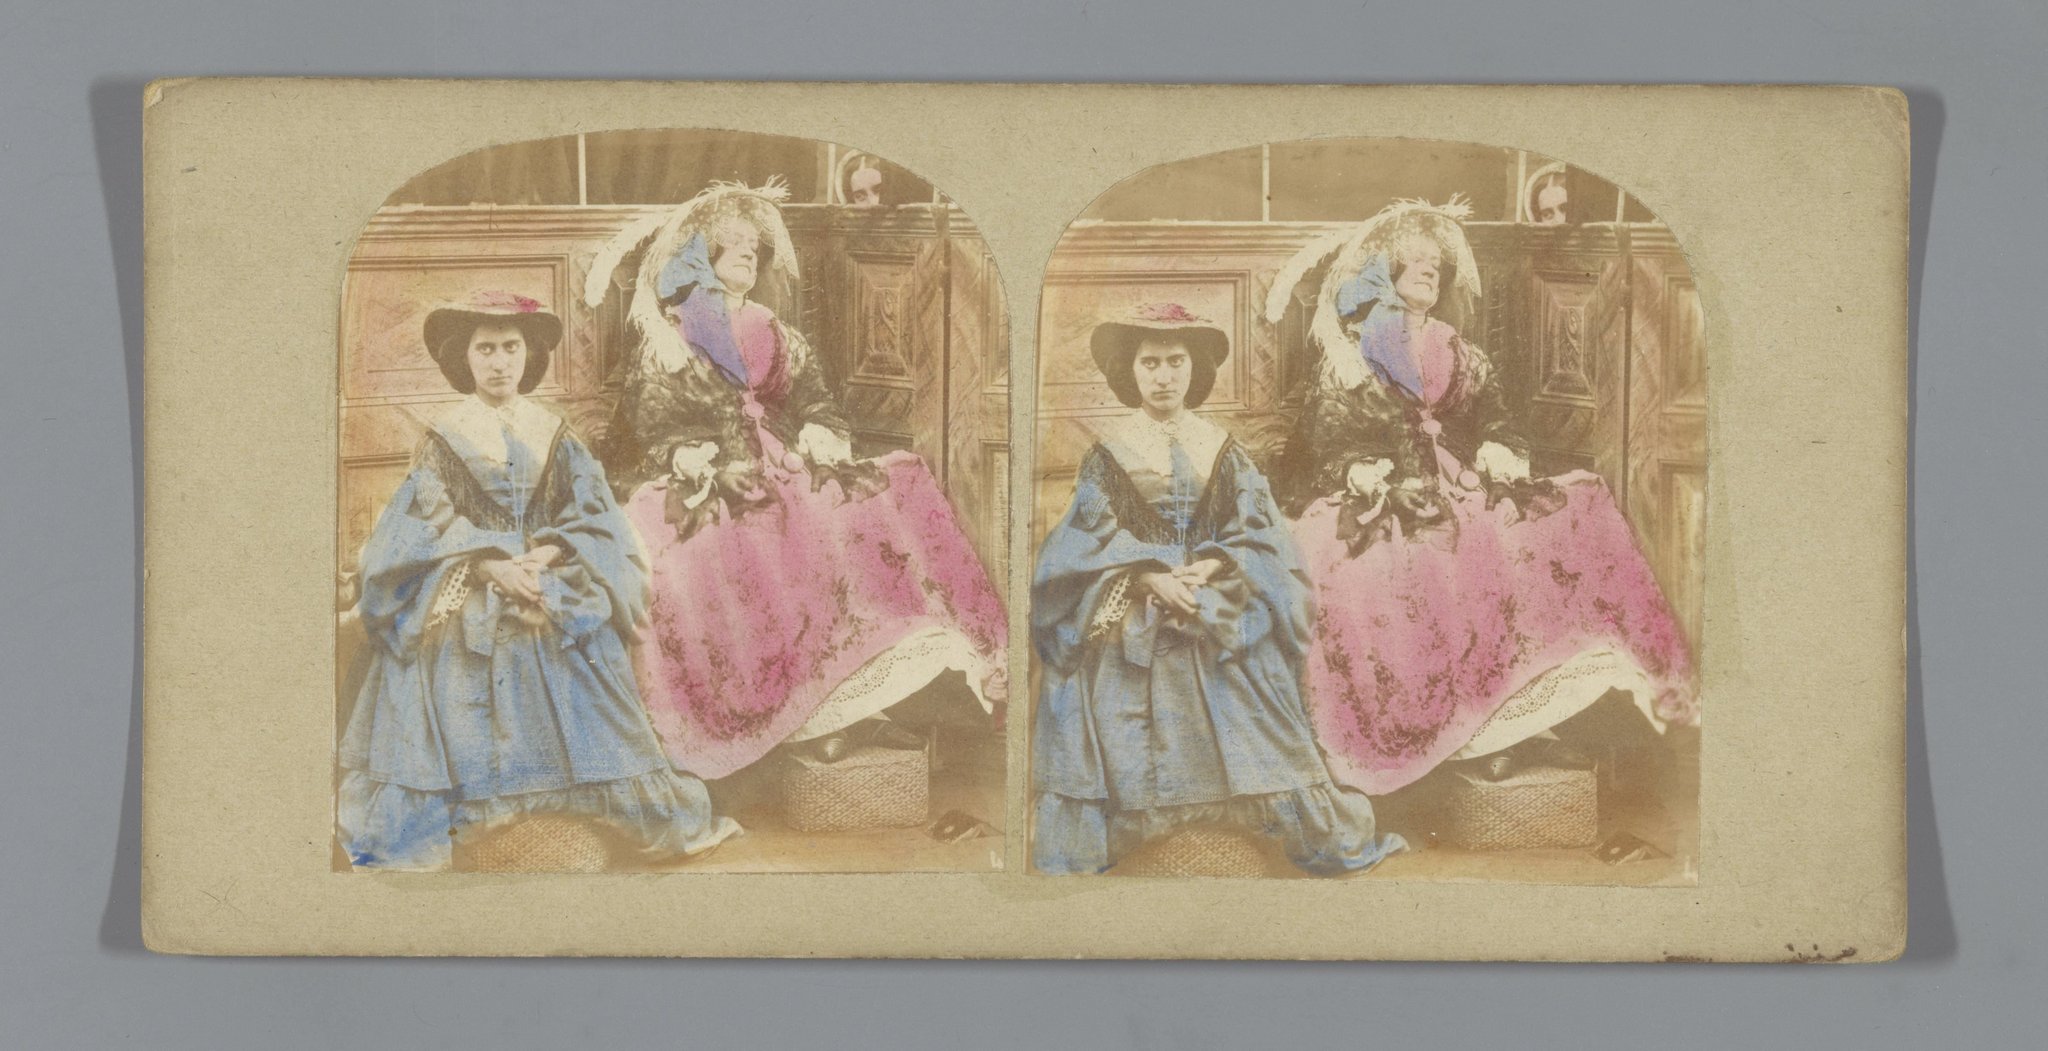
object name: stereograph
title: Twee vrouwen worden begluurd door een derde vrouw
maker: Anonymous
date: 1852-1863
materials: cardboard, paper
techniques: albumen print, hand coloring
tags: sleeping; unconsciousness